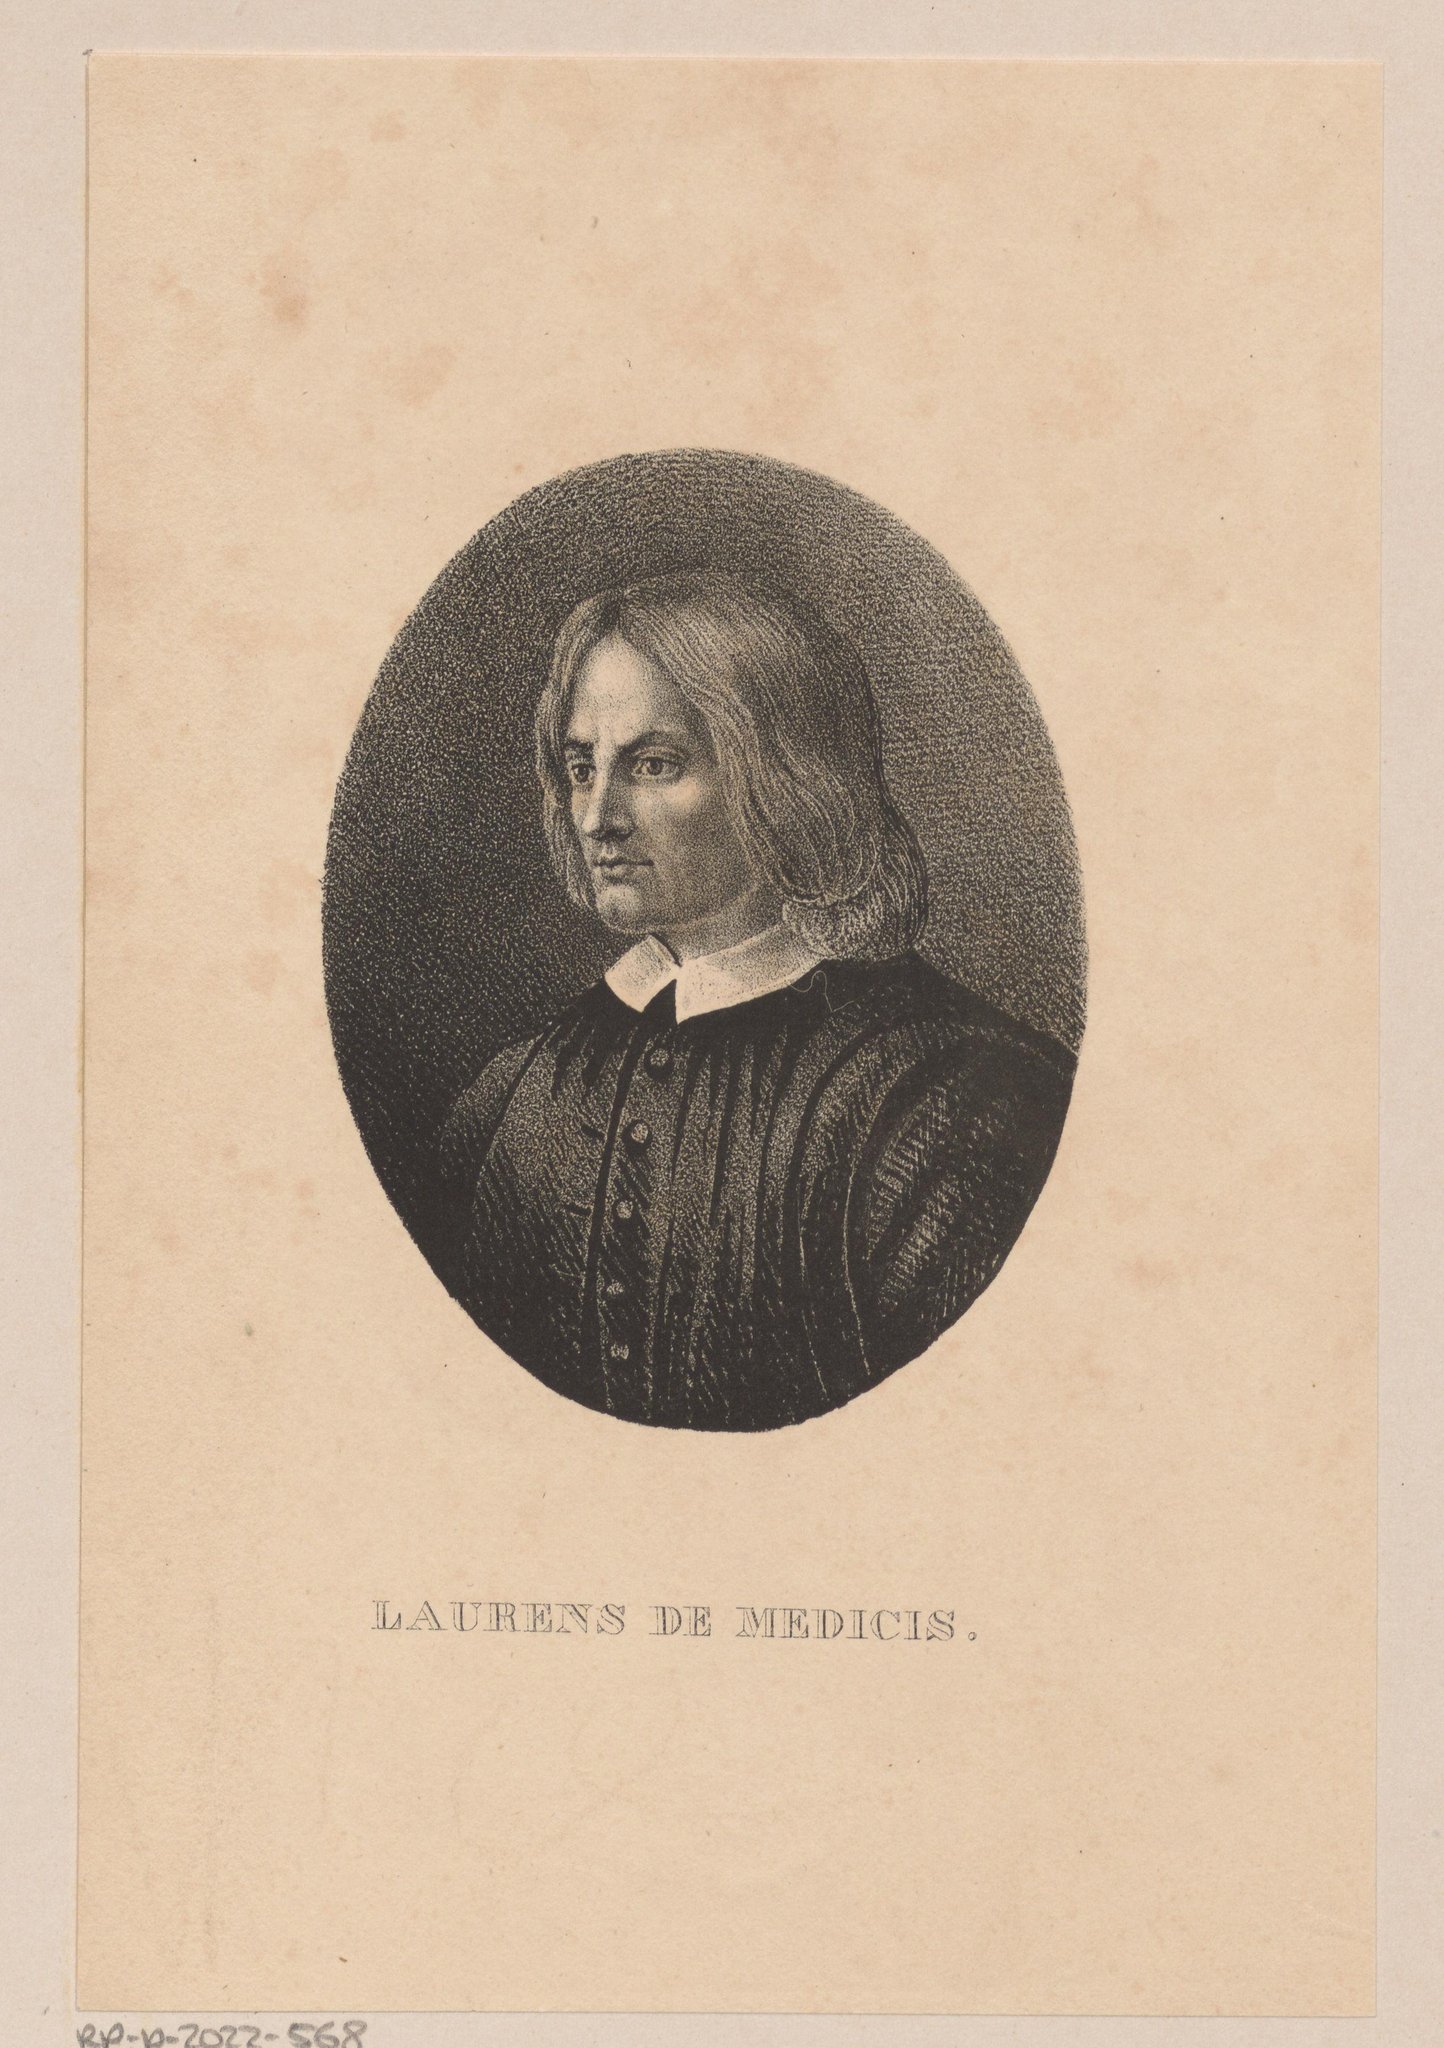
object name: print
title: Laurens de Medicis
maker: Anonymous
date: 1700-1850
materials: paper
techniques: lithograph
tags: historical persons